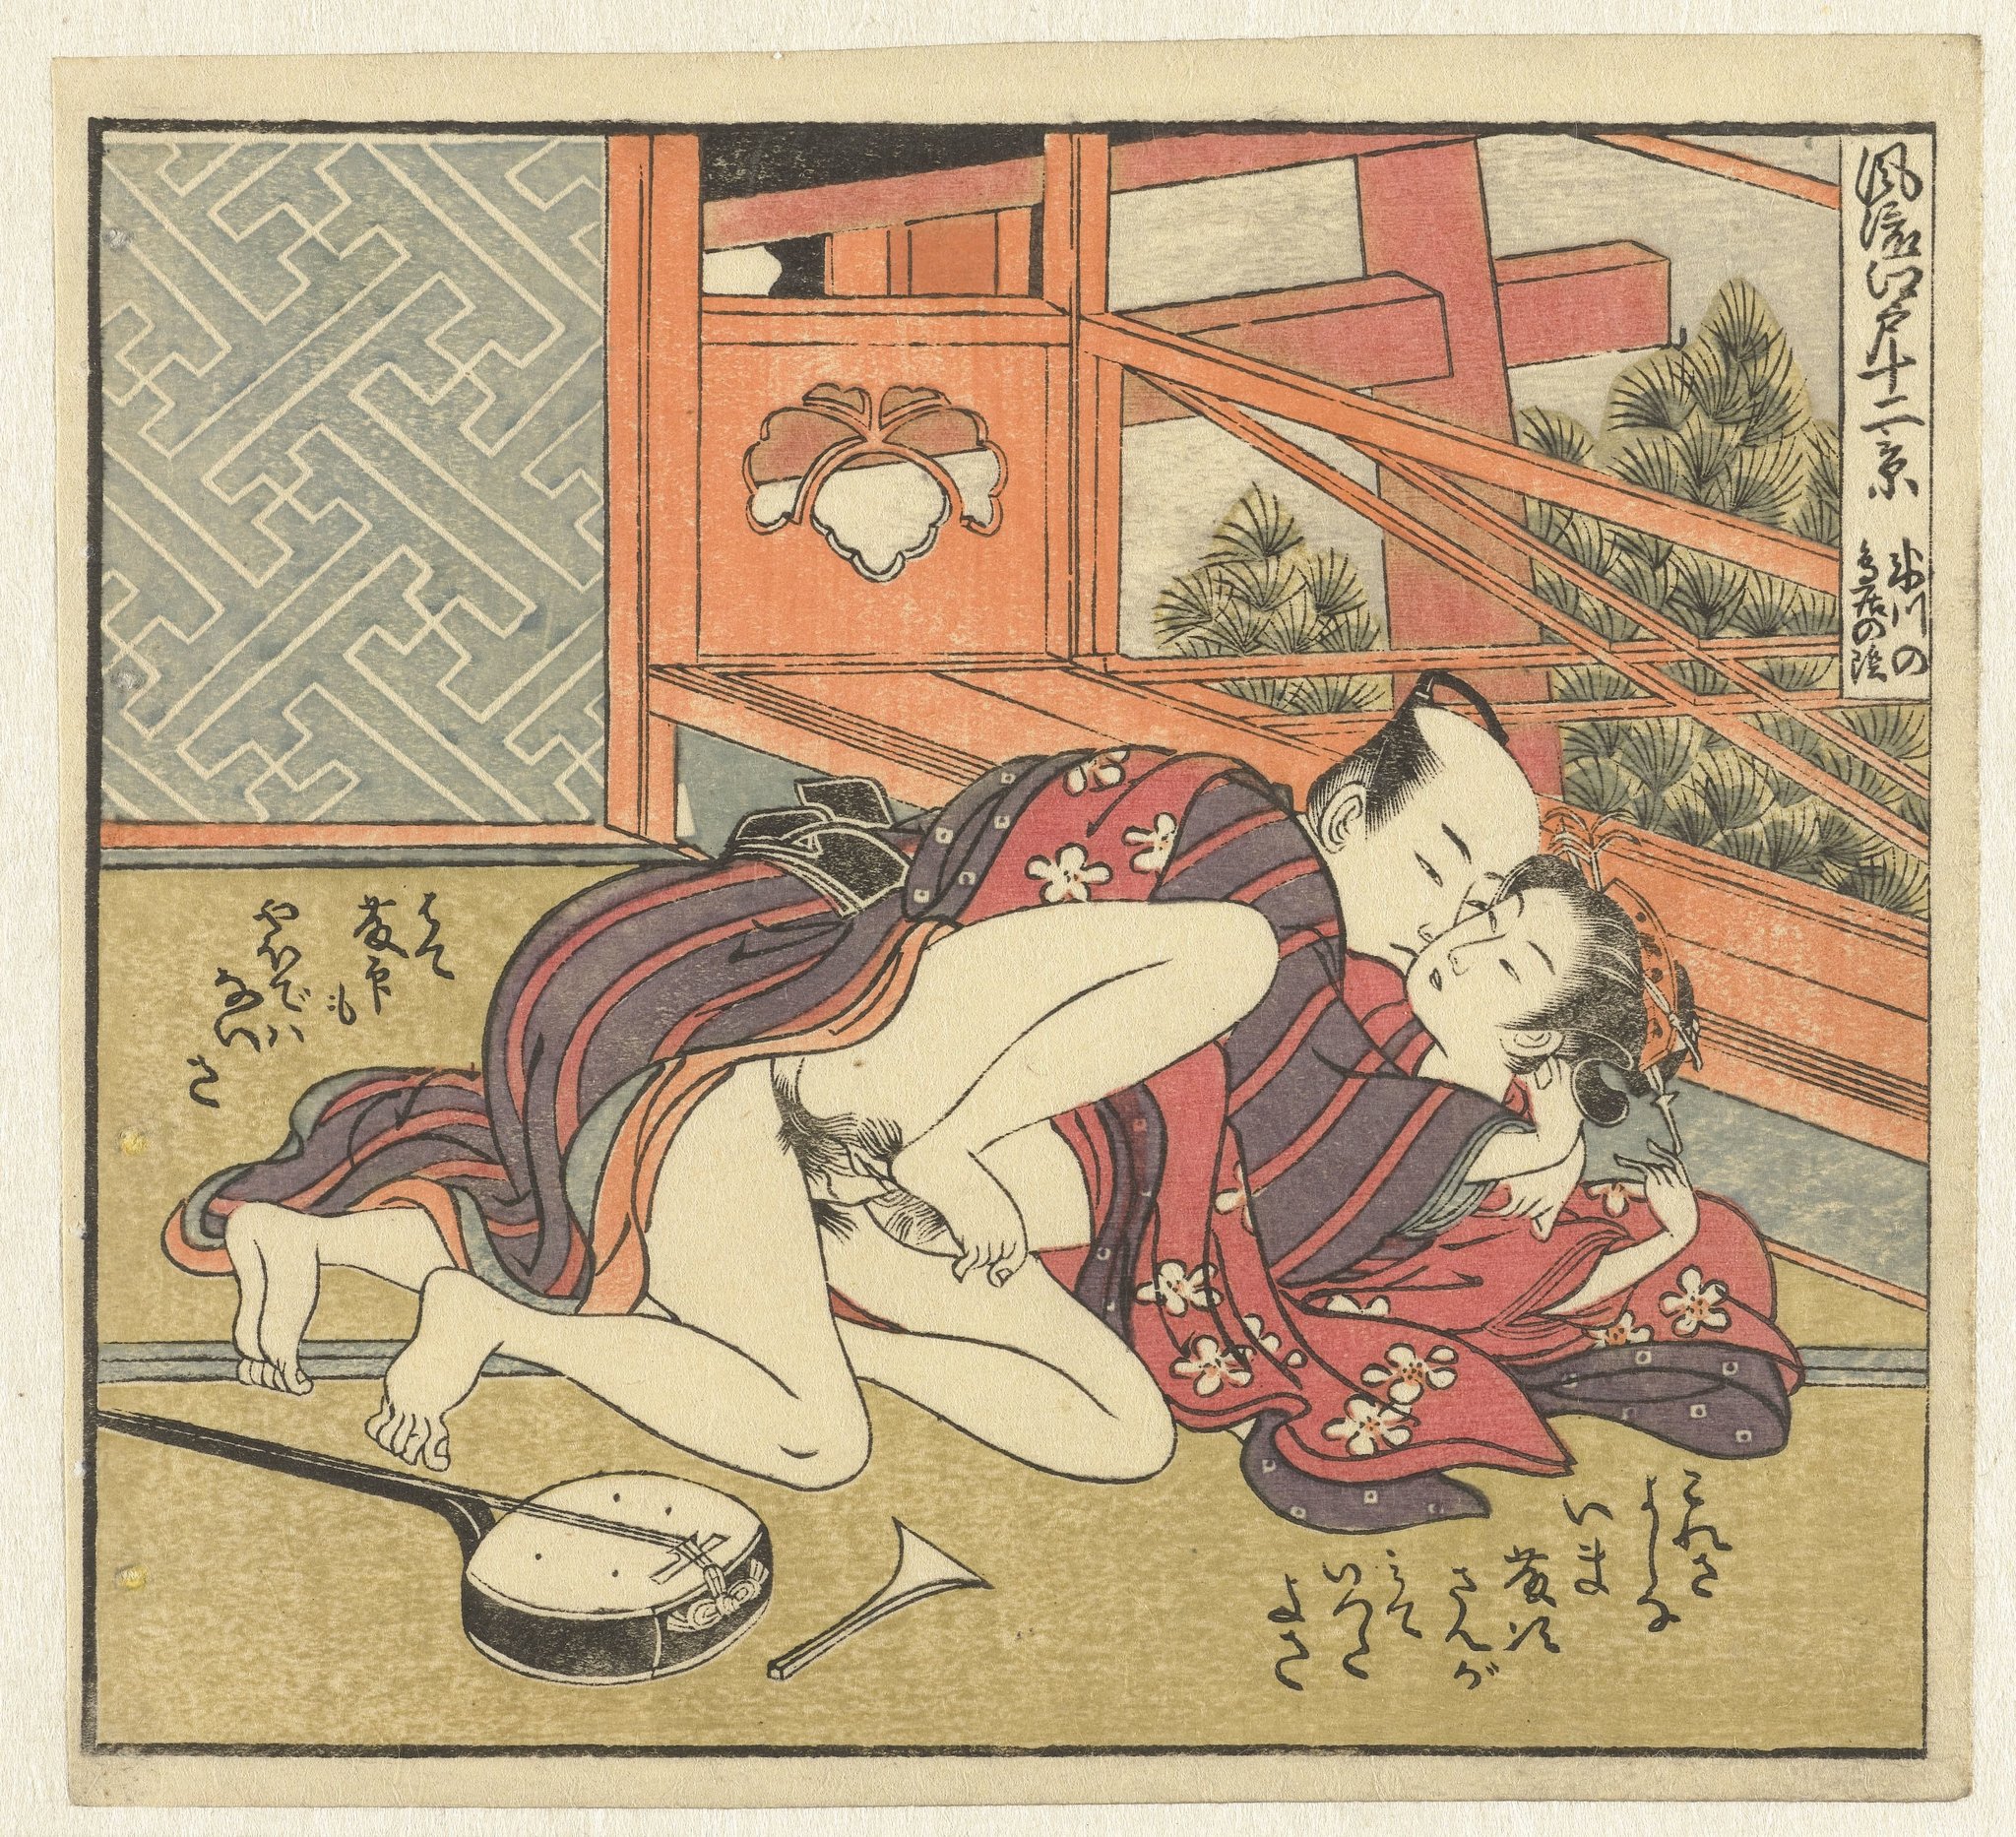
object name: shunga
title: Liefdespaar bij shamisen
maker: isoda kôryûsai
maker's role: print maker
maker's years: 1735-1790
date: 1770-1775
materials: paper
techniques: woodcut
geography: japan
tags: coitus, cohabiting, sexual intercourse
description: Man, de liefde bedrijvend met jonge courtisane; op de vloer een shamisen (Japans snaarinstrument)